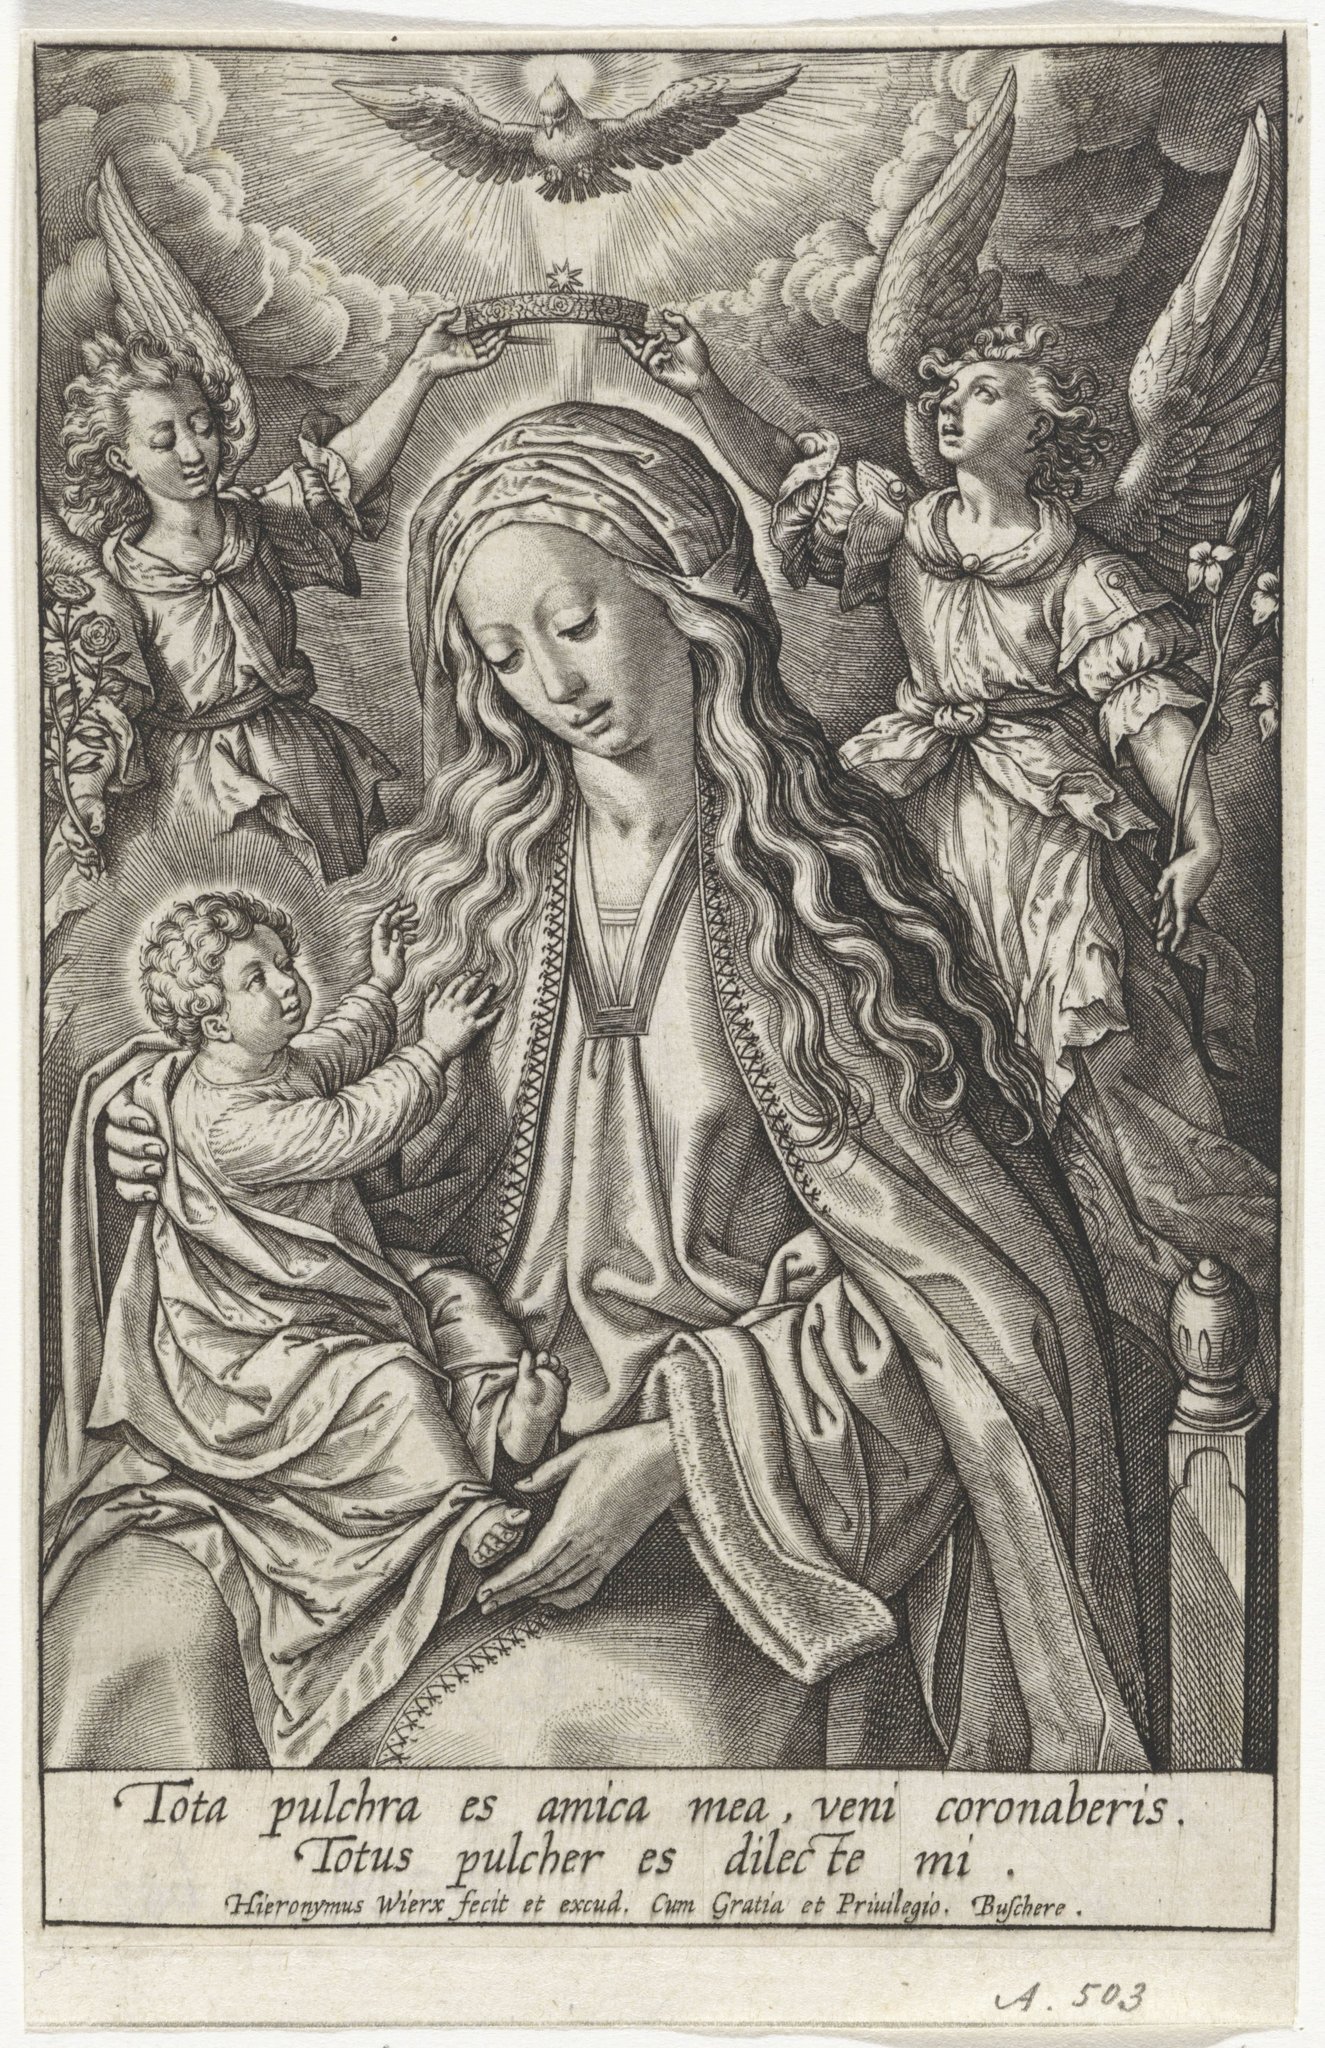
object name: print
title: Maria met Christuskind, gekroond door twee engelen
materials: paper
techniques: engraving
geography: antwerp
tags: coronation of mary by one or more angels, madonna (i.e. mary with the christ-child) accompanied or surrounded by others (+ angel(s)), holy ghost represented as a dove (in flames)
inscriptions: collector's mark: Lugt 2228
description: Maria zit met het Christuskind op schoot. Het Kind reikt naar haar. Maria wordt gekroond door twee engelen. Boven haar hoofd de duif van de Heilige Geest. In de marge een tweeregelig onderschrift in het Latijn.